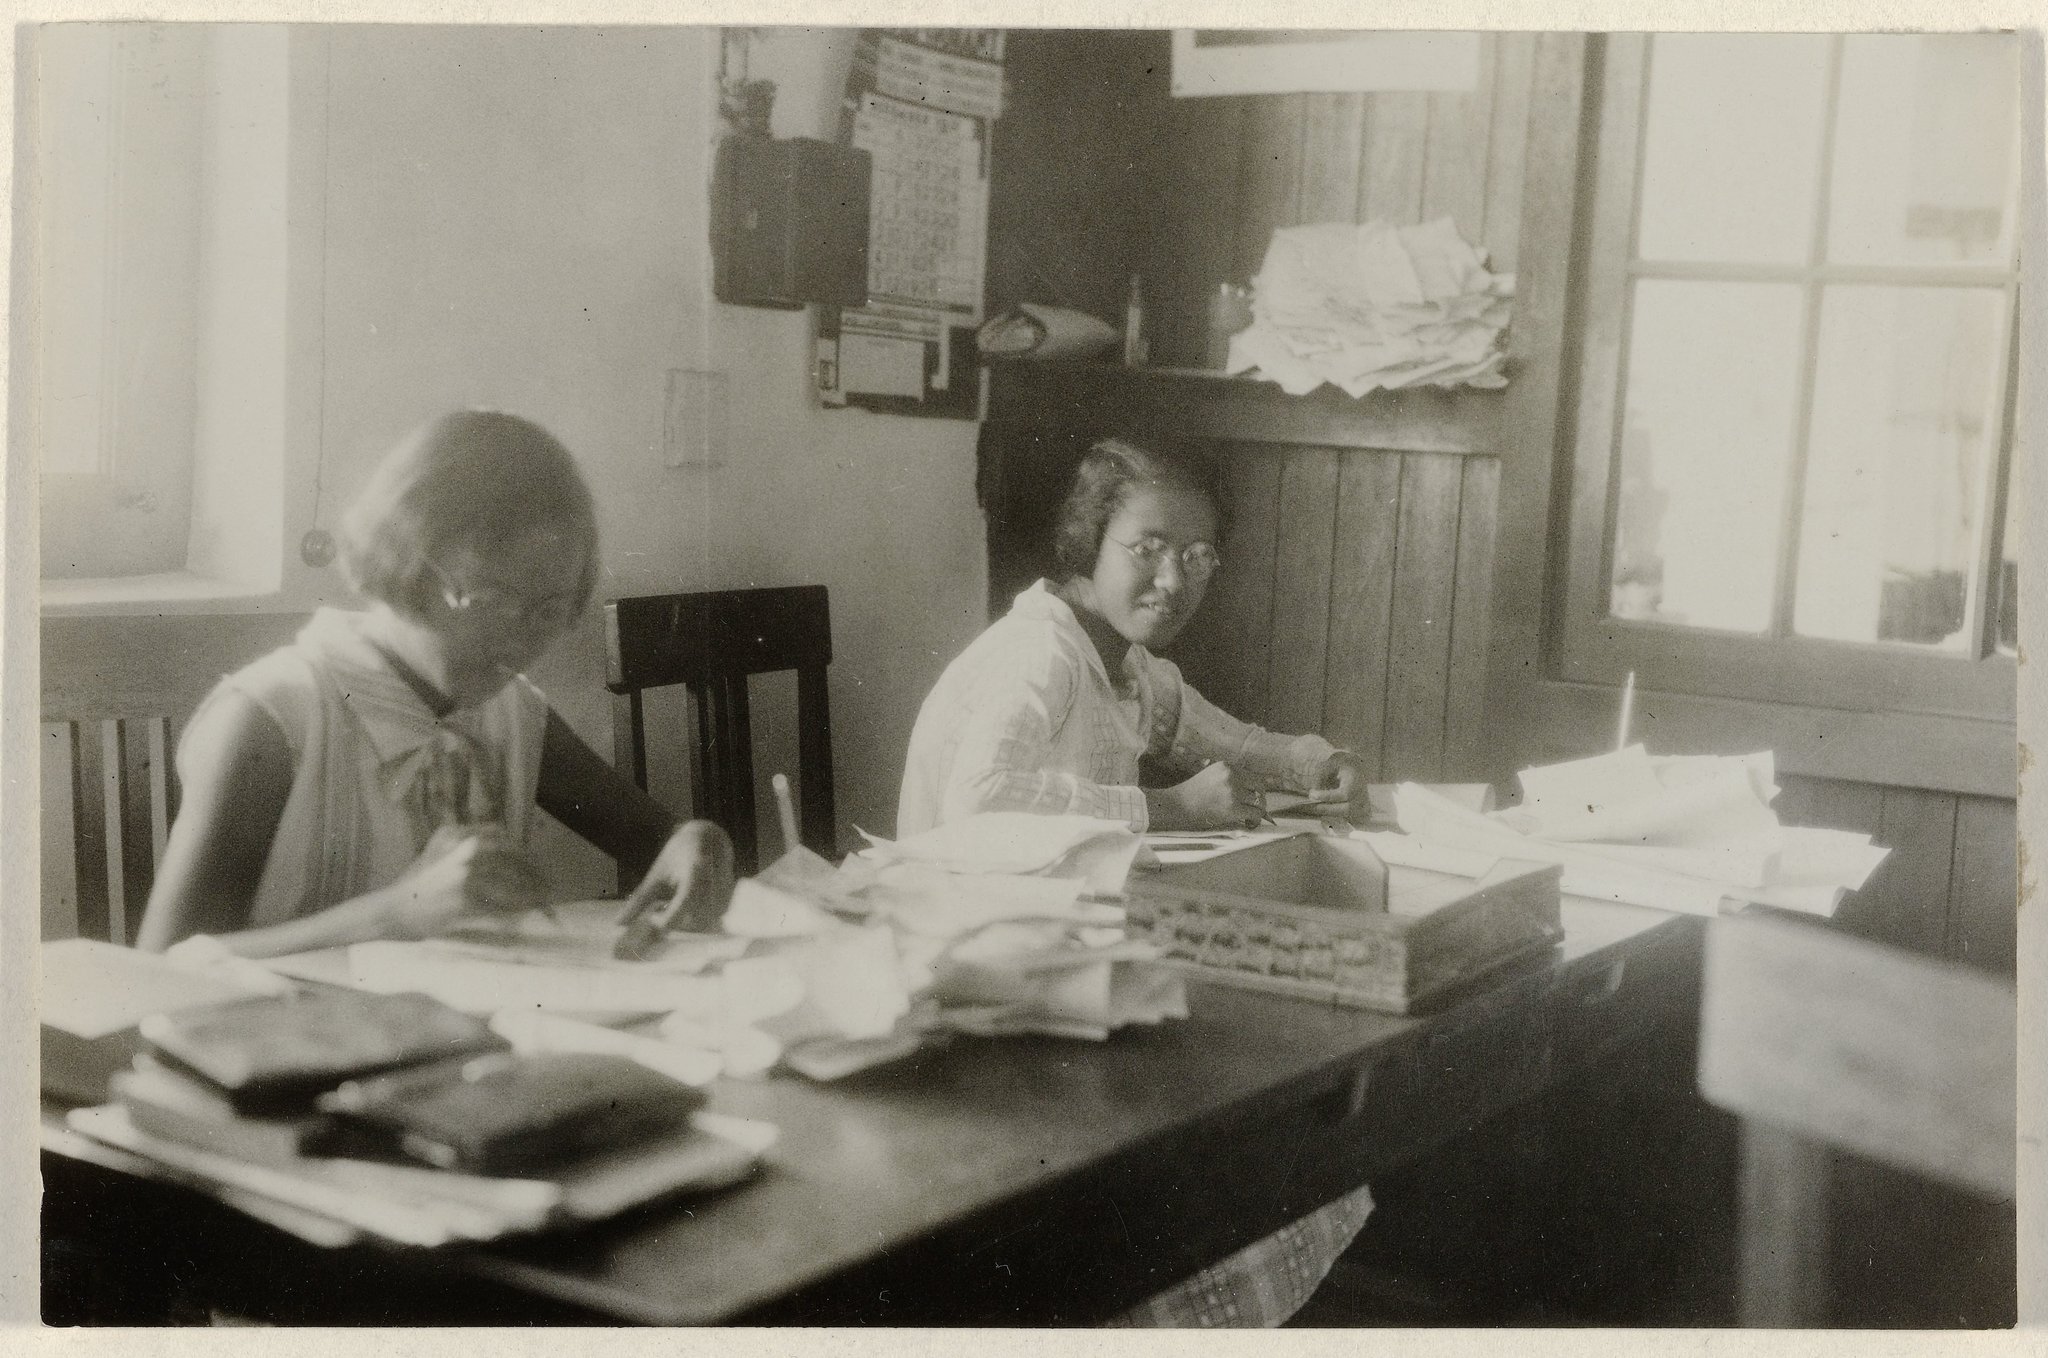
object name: photograph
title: Twee meisjes achter een bureau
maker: Anonymous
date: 1900-1935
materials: photographic support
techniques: collodion silver print, gelatin silver print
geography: medan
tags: dutch east indies, the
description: Twee meisjes achter een bureau in een kantoor van de Deli Courant. Onderdeel van een groep van 49 losse zwart-wit foto's van verschillend formaat over de uitgeverij en drukkerij van de krant Deli Courant te Medan in de periode 1885-1947.